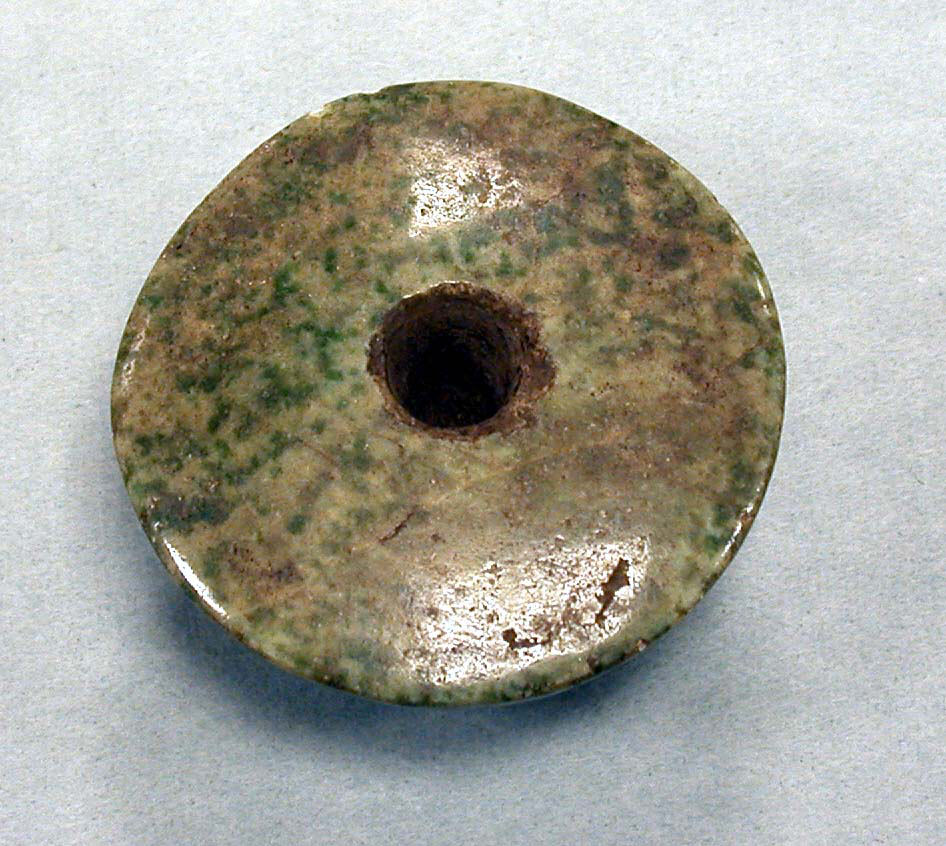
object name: earflare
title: Stone Earflare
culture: mexican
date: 1501-1600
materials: stone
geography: mexico